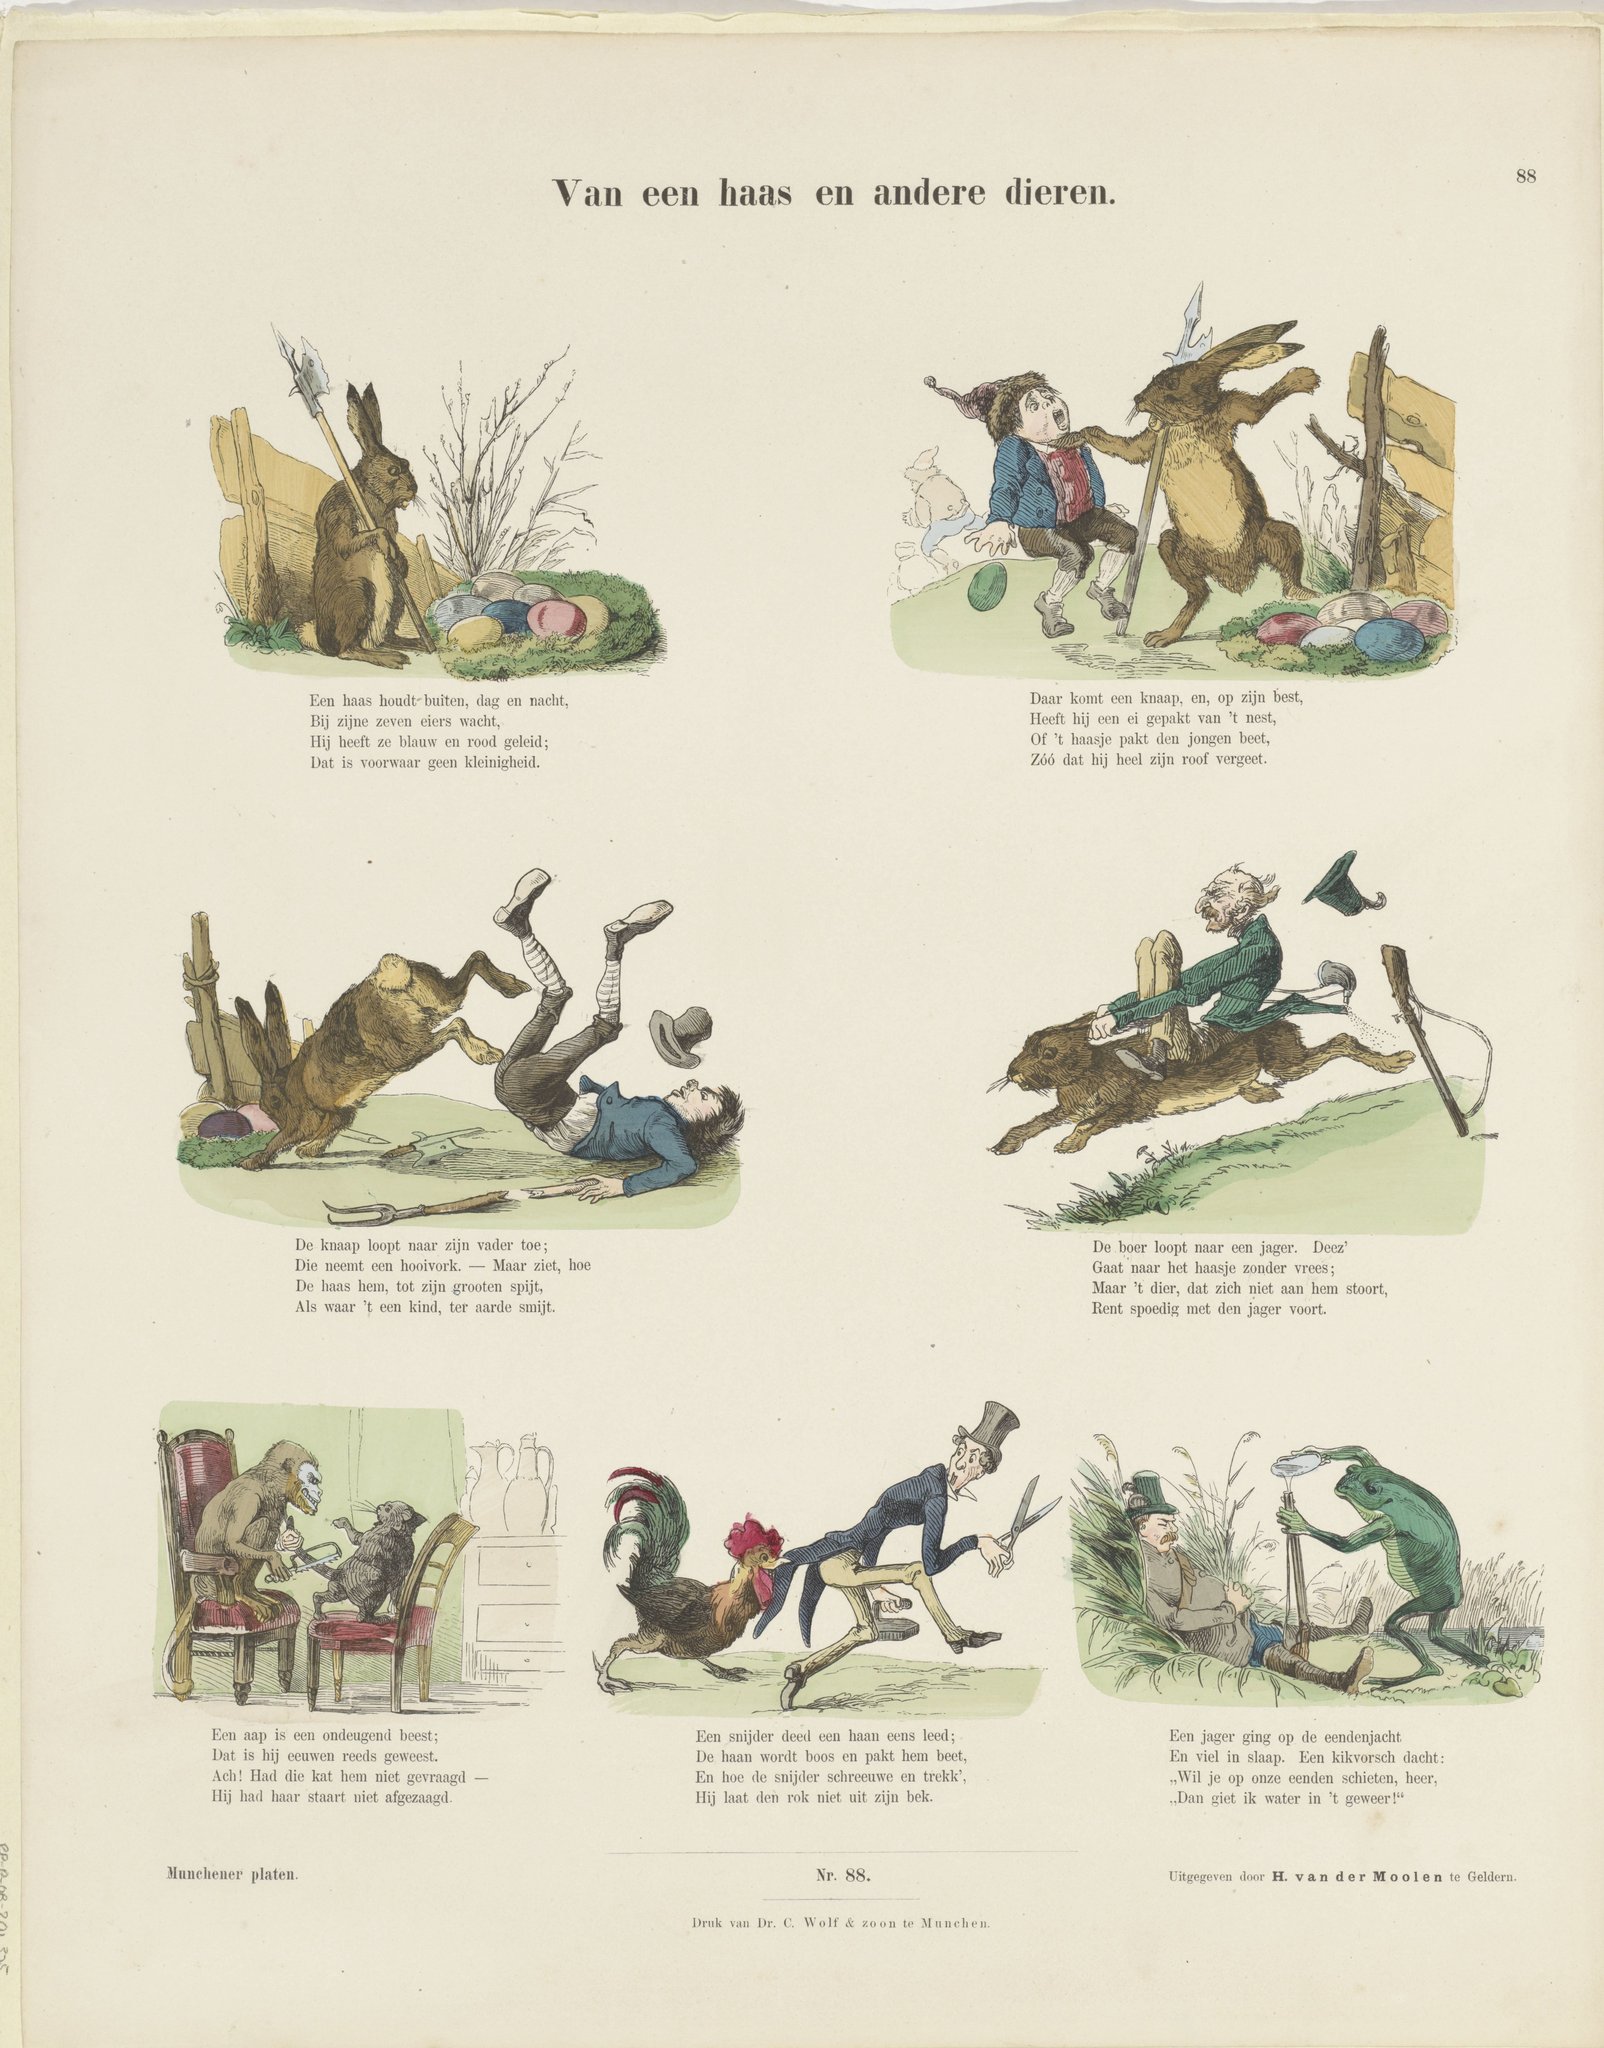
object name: popular print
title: Van een haas en andere dieren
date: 1820-1843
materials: paper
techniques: colour, letterpress printing, engraving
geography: germany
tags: animals, easter rabbit, animals acting as human beings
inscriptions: collector's mark: Lugt 2760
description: Blad met 12 voorstellingen uit het het verhaal van de twee deugnieten Kees en Jan die honing stelen en vervolgens gestoken worden door bijen. Onder elke afbeelding een tweeregelig vers. Genummerd midden onder: Nro. 87. Genummerd rechtsboven: 87.